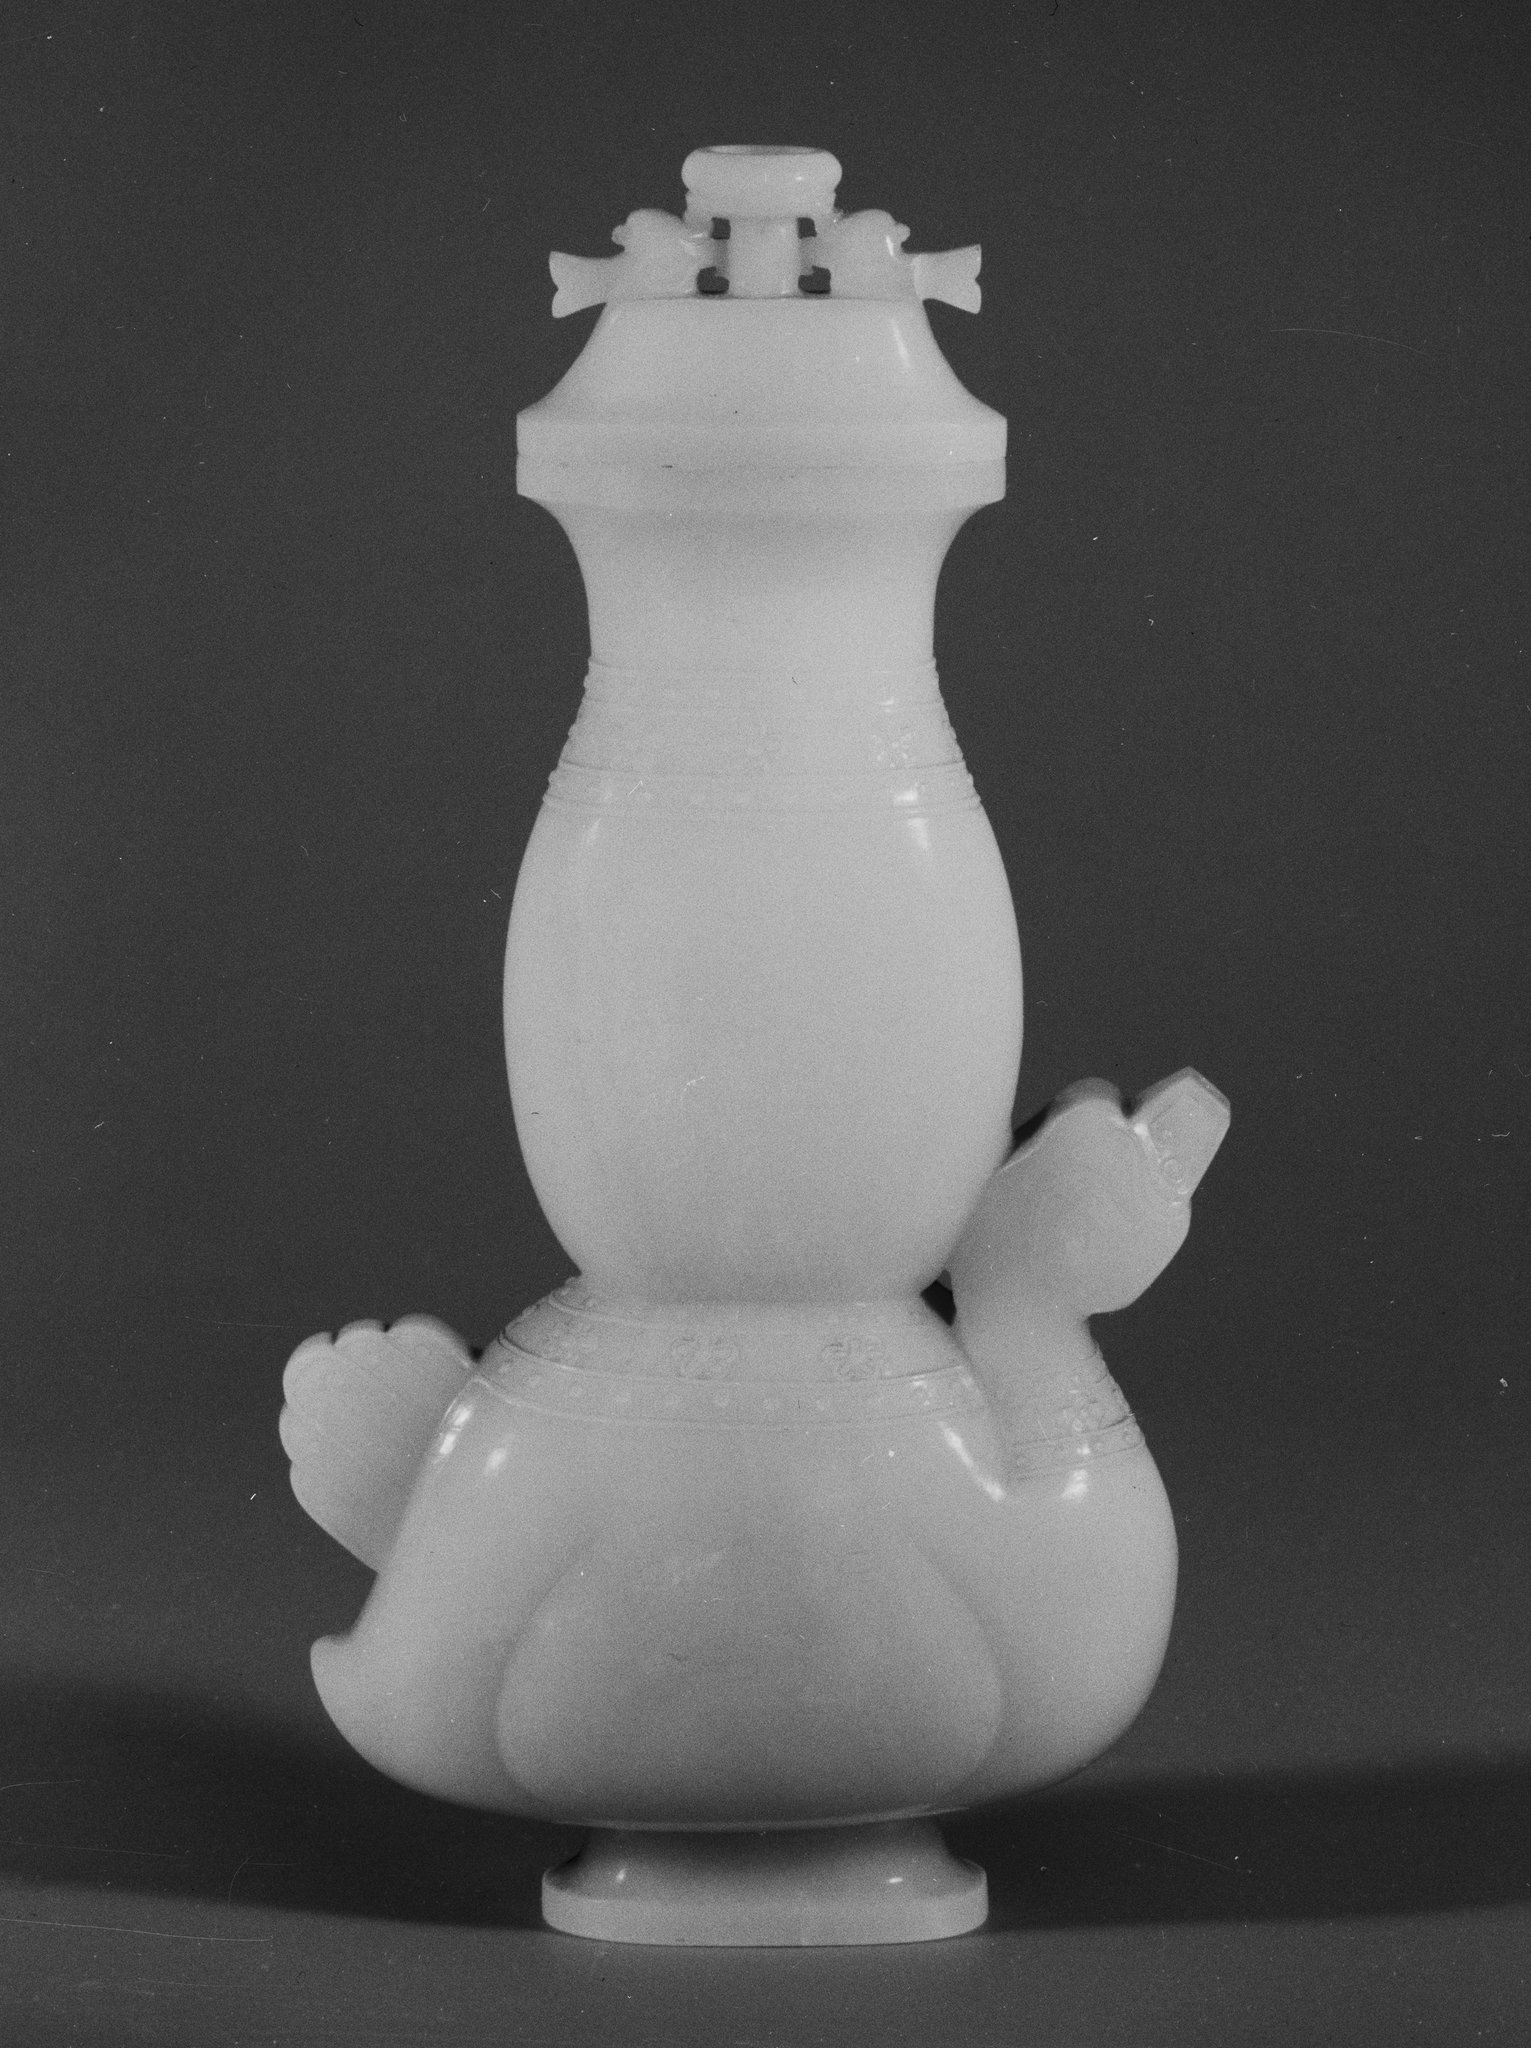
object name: wine pot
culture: chinese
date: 1701-1800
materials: jade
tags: birds